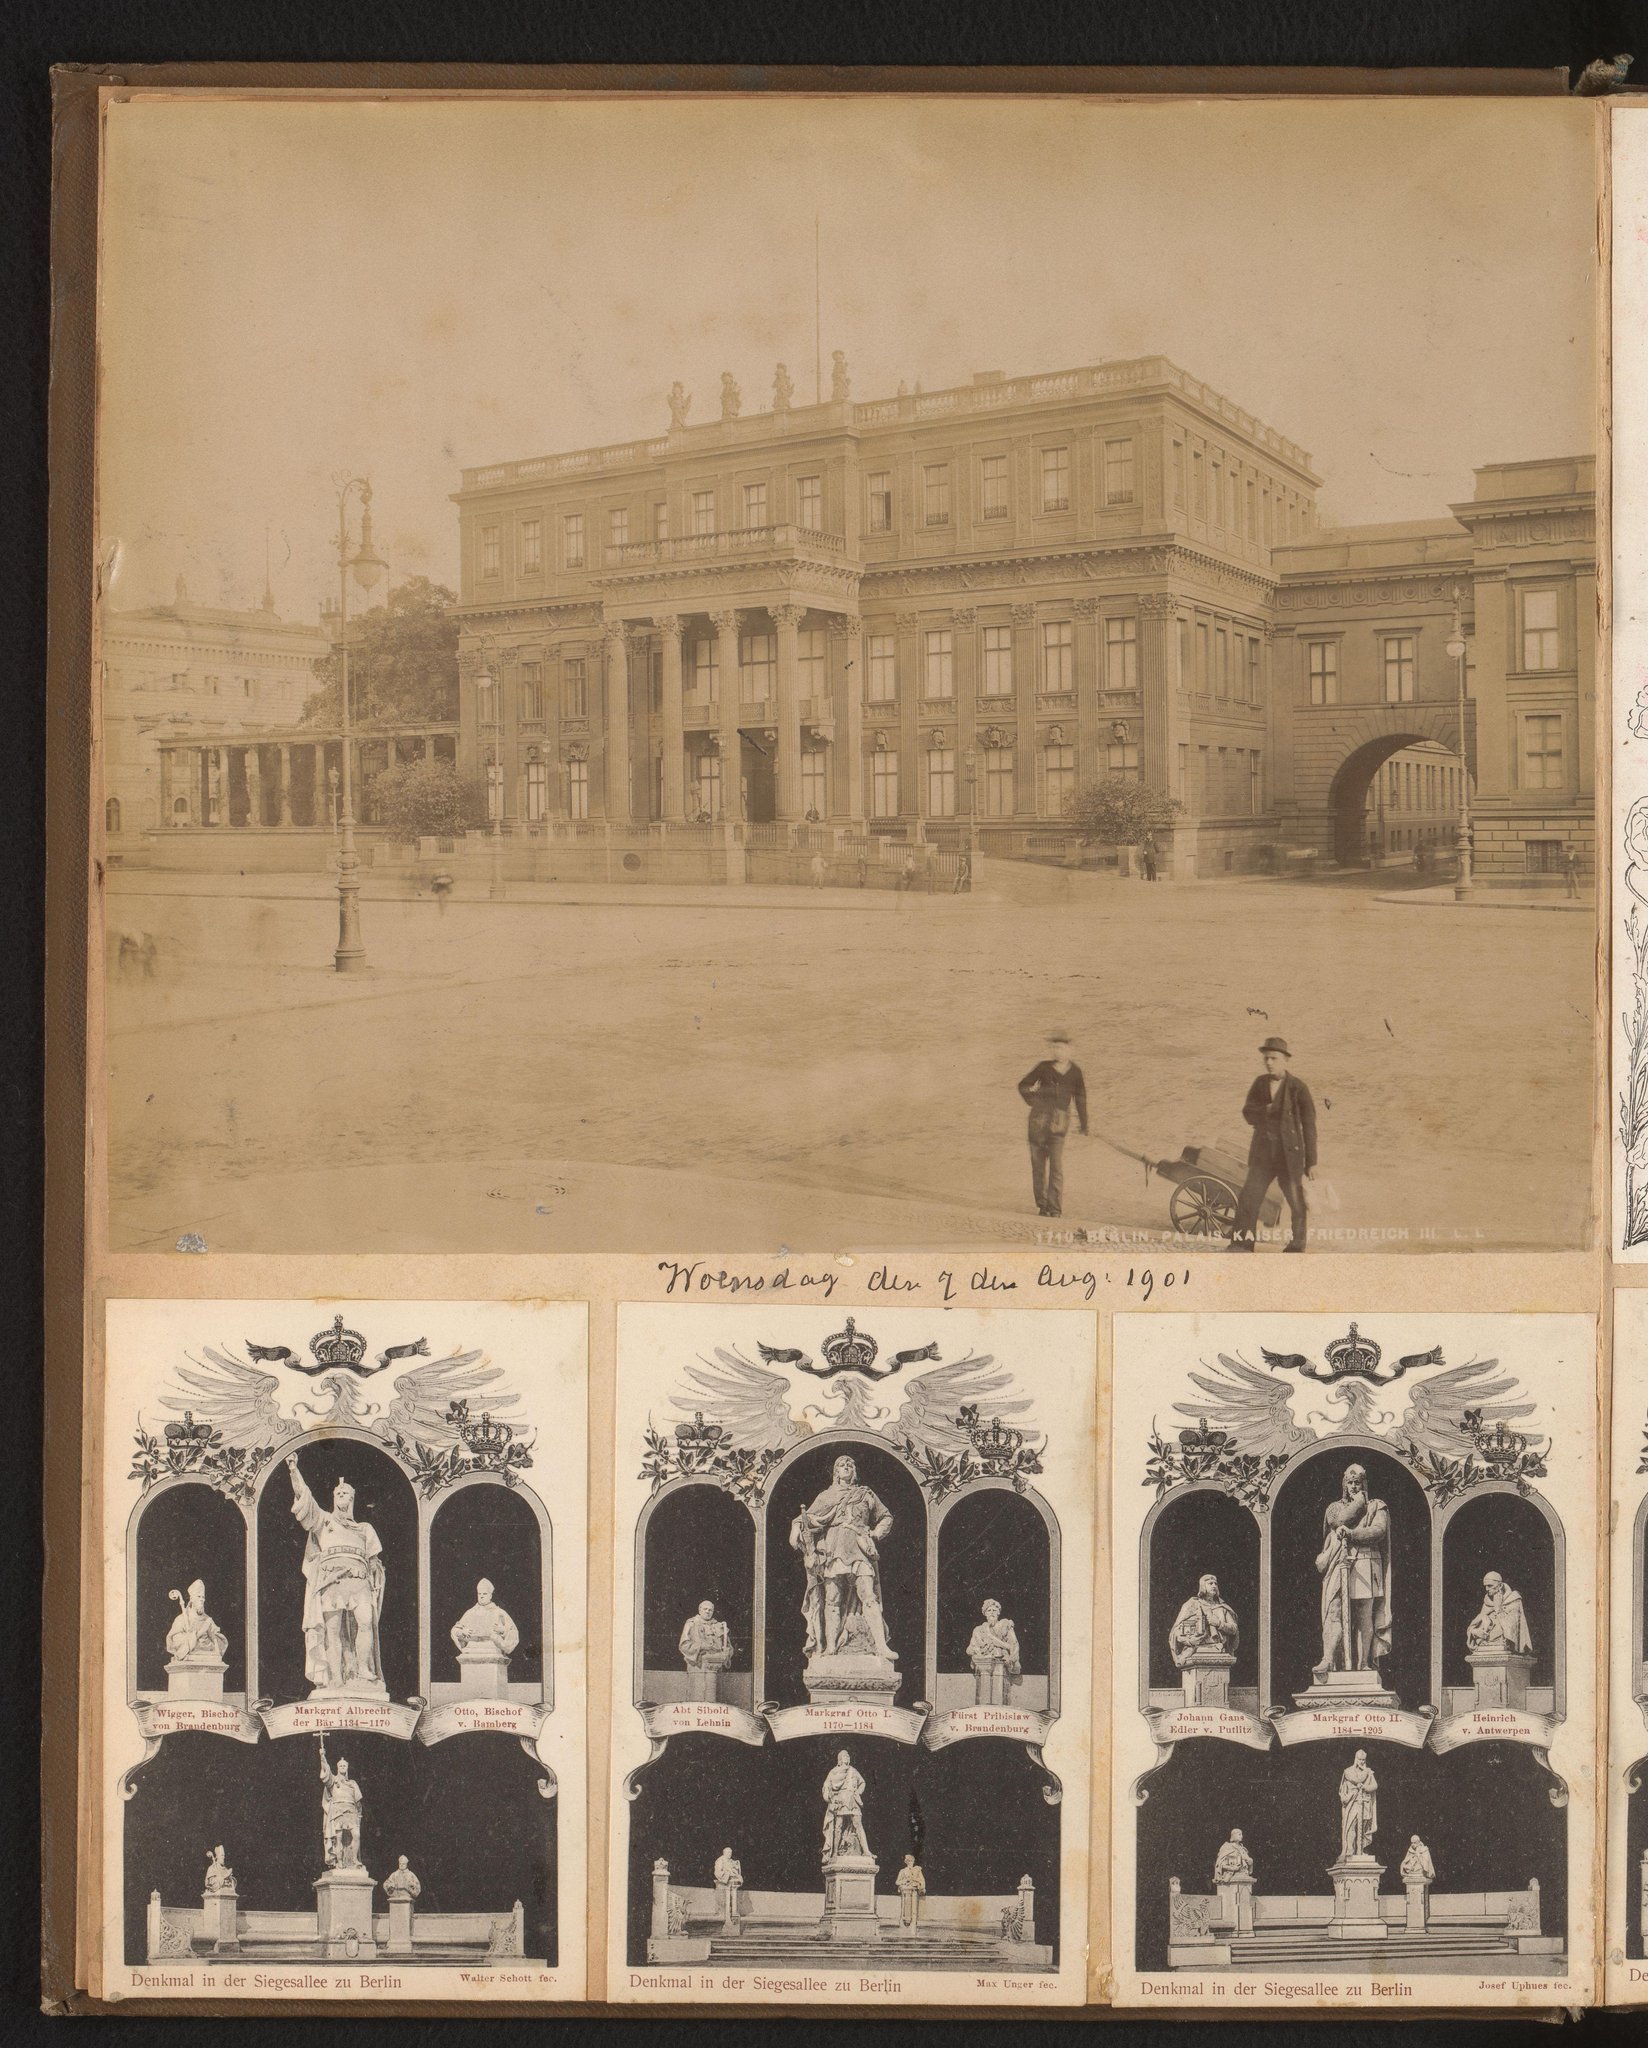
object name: album leaf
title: Kronprinzenpalais in Berlijn en beelden langs de Siegesallee, Berlijn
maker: Anonymous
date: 1896-1901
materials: paper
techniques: albumen print, photograph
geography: paris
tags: palace, piece of sculpture, reproduction of a piece of sculpture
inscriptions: title: ‘1710 Berlin. Palais Kaiser Wilhelm Friedreich III. L.L.’, title: ‘Denkmal in der Siegesallee zu Berlin (...)’, inscription: ‘Woensdag den 7den Aug. 1901’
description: Deze foto en fotomechanische afdrukken maken deel uit van een album.